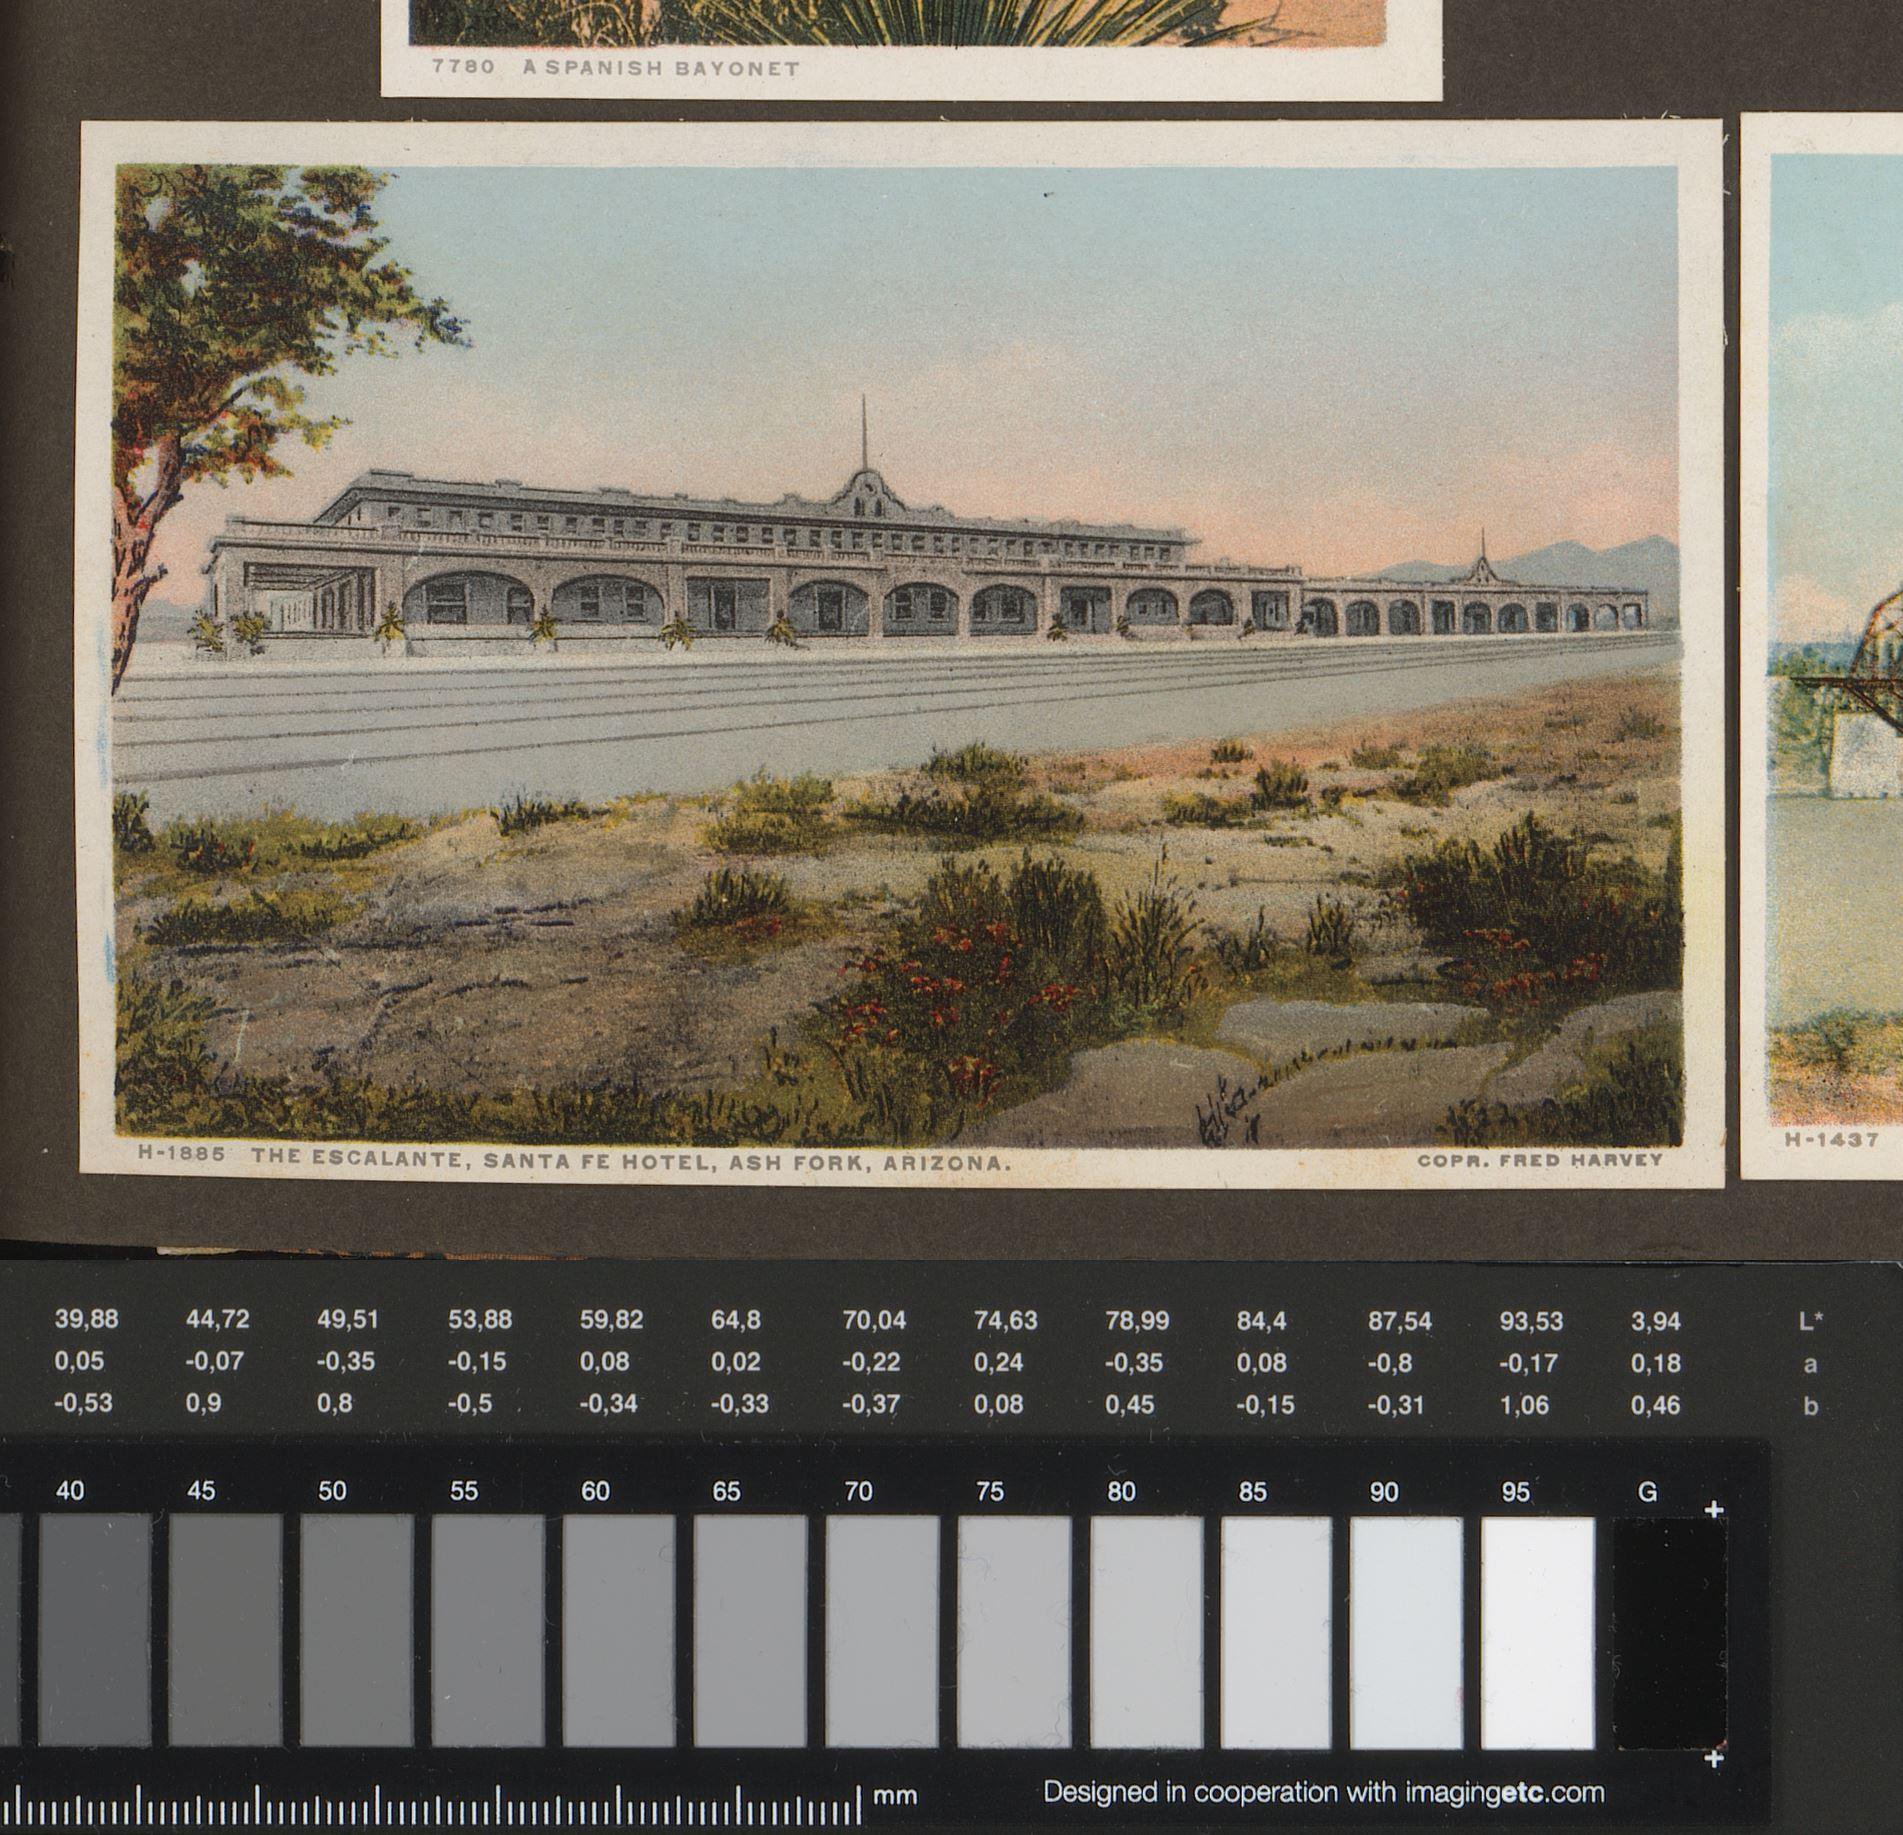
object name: ansichtkaart, prentbriefkaart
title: The Escalante, Santa Fe Hotel, California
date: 1928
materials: paper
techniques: lithograph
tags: hotel, hostelry, inn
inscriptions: number: ‘H-1885’, name: ‘Copr. Fred Harvey’